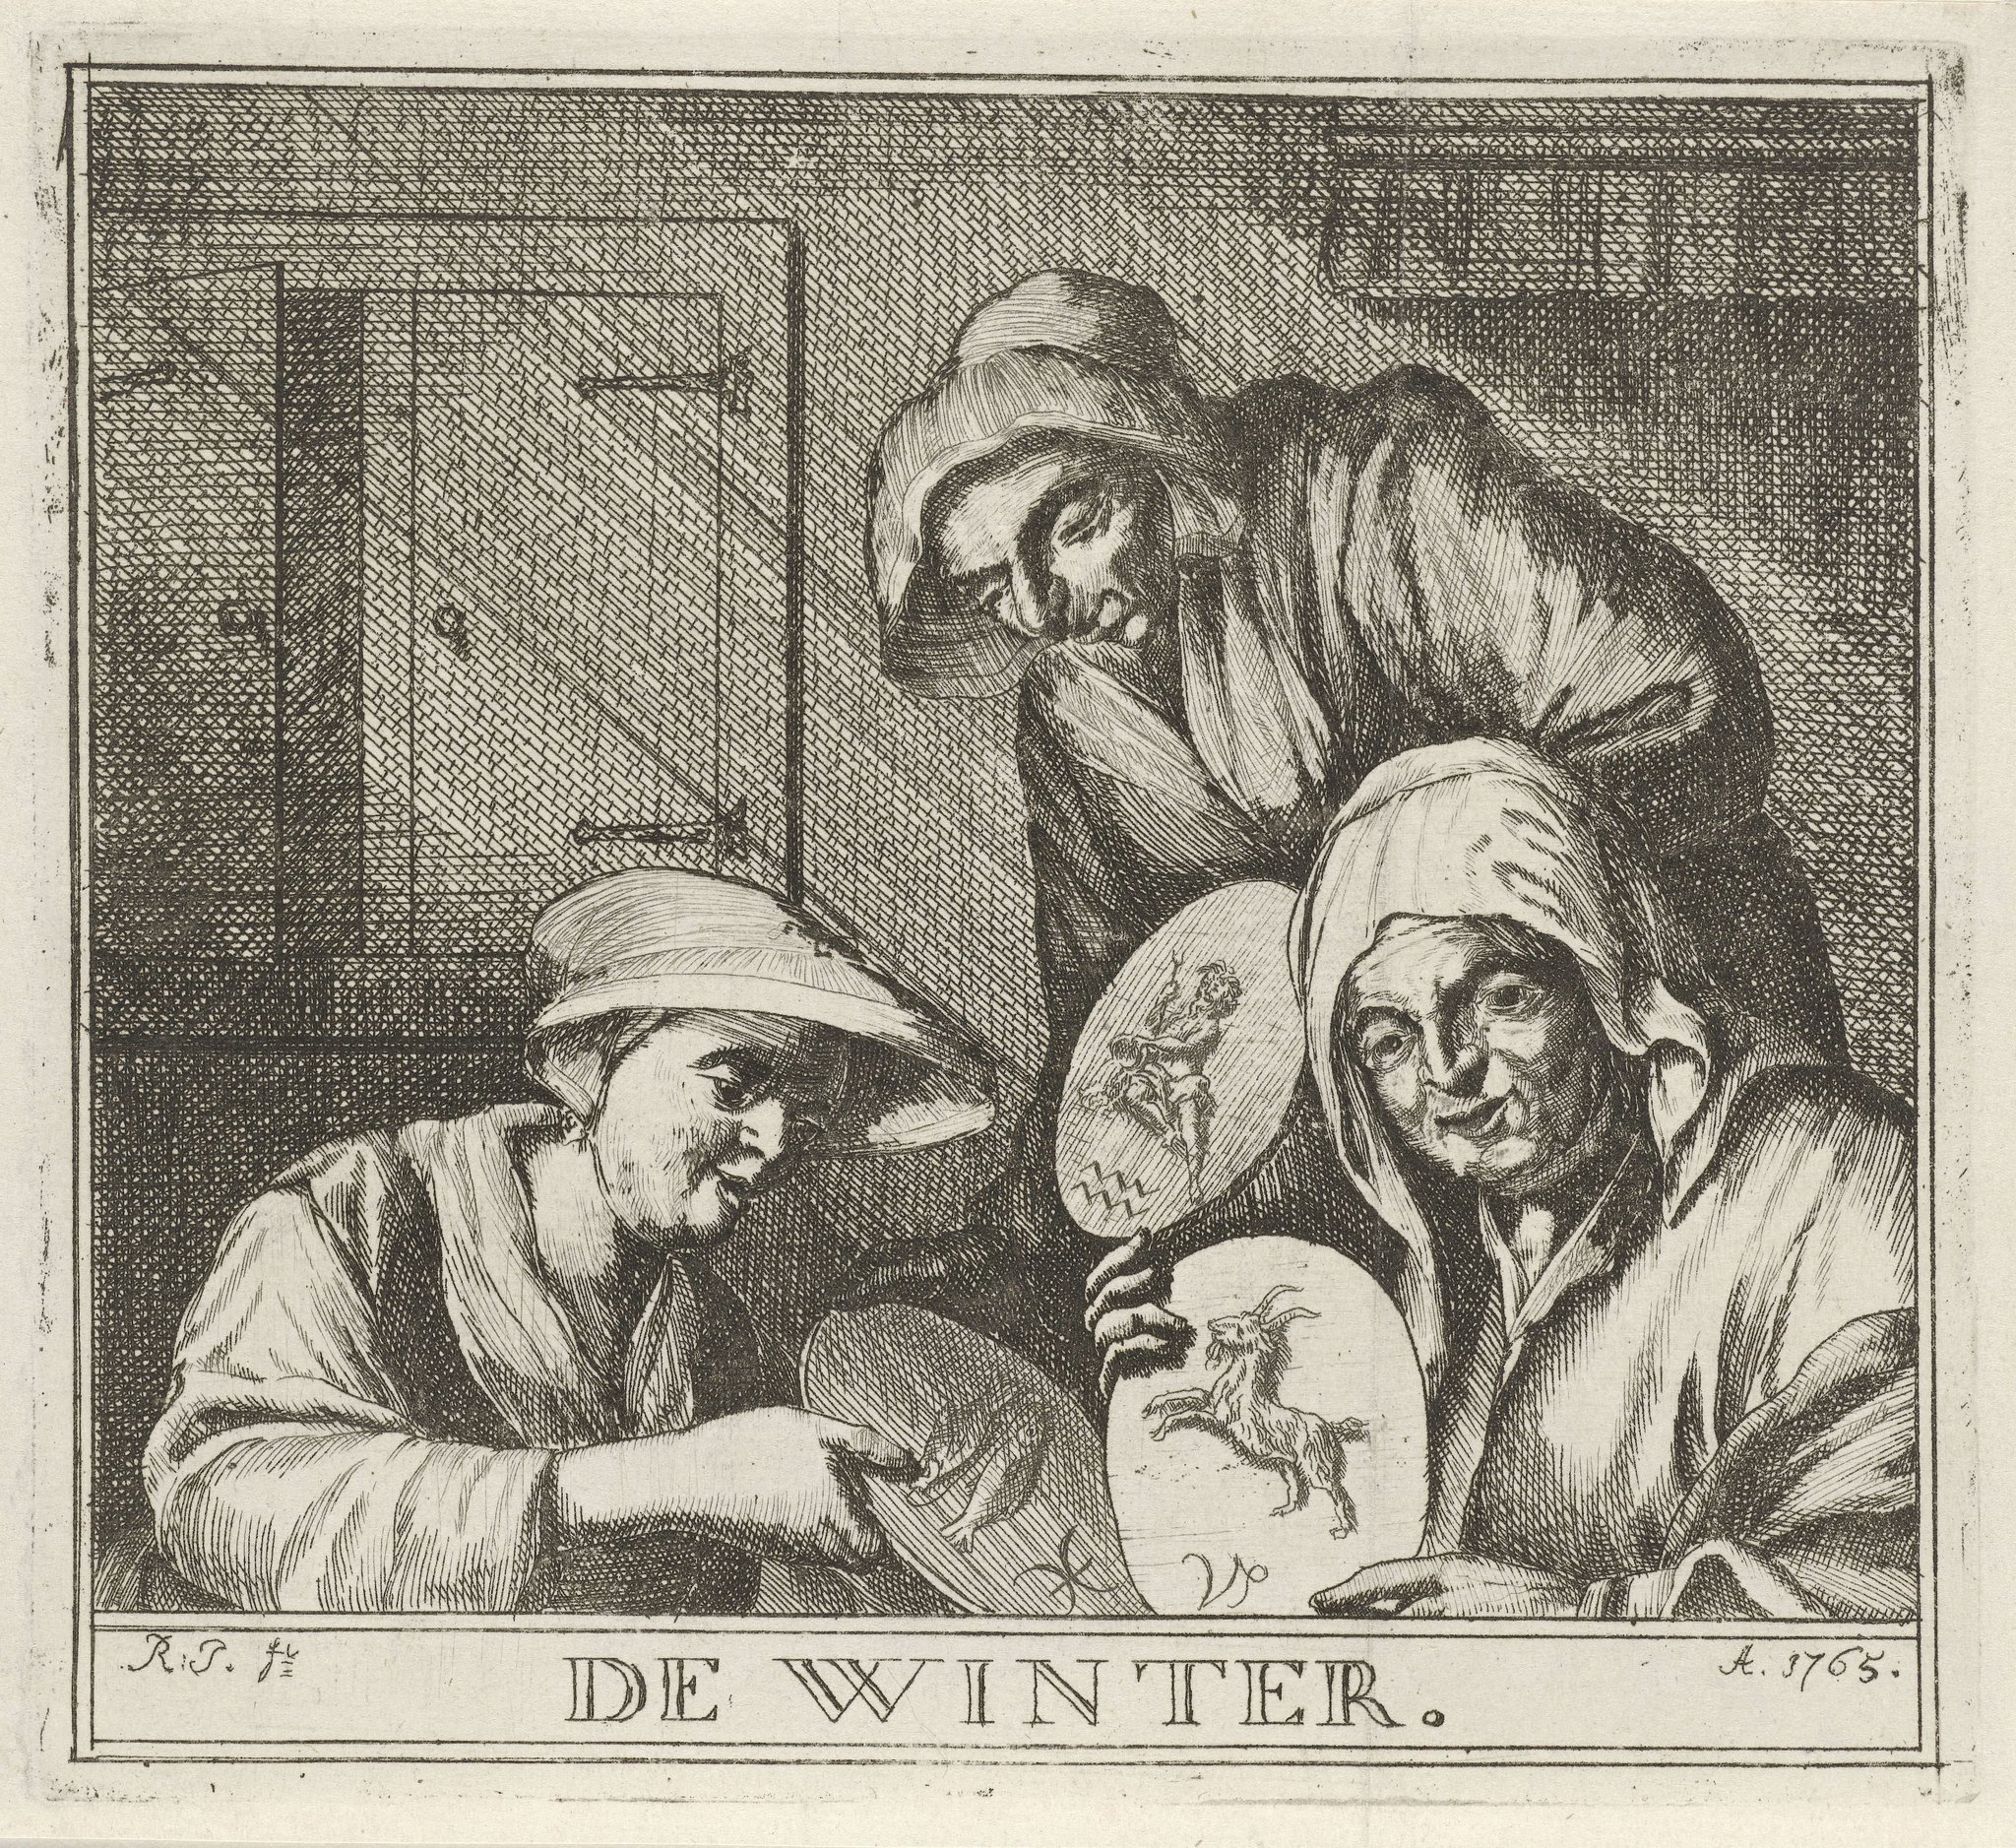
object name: titelprent, frontispice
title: De Winter.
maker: rienk jelgerhuis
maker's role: draughtsman, print maker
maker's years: 1729-1806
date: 1765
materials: paper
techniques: engraving, etching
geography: leeuwarden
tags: zodiacal signs of the winter season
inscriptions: collector's mark: Lugt 2228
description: Interieur met drie boerinnen die elk een rond bord met daarop een teken van de dierenriem uit het winterseizoen vasthouden, respectievelijk: Ram, Waterman, Vissen. Titelprent voor een serie van dertien met wintertaferelen.